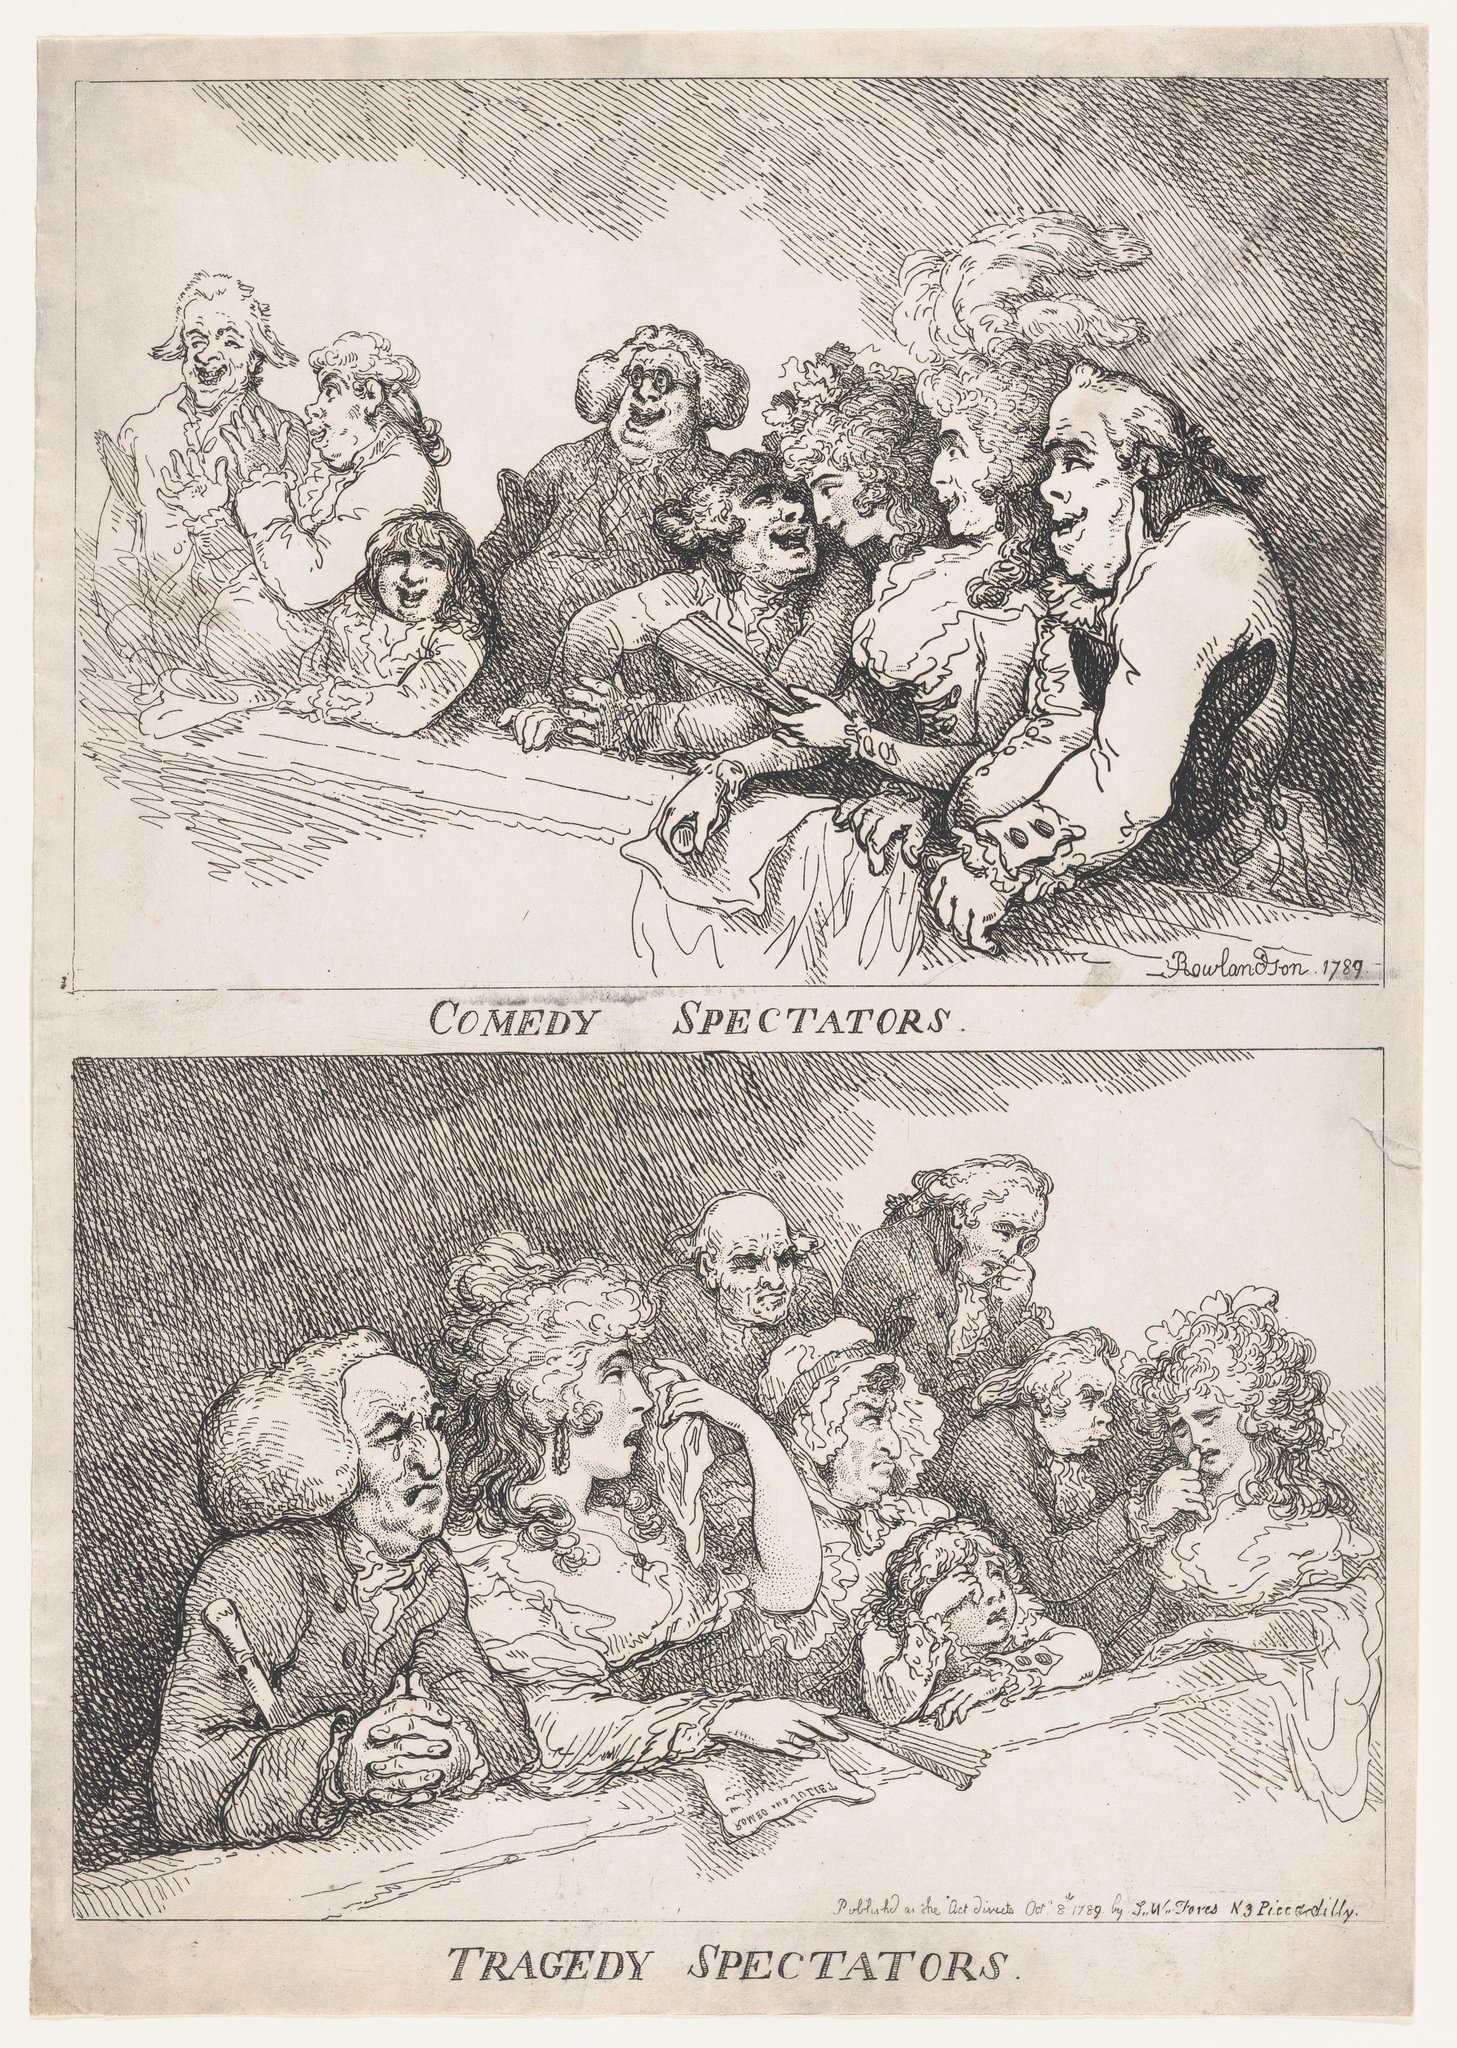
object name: print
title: Comedy Spectators, Tragedy Spectators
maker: thomas rowlandson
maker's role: artist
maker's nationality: british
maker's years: 1757-1827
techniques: etching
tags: satire,men,women,spectators